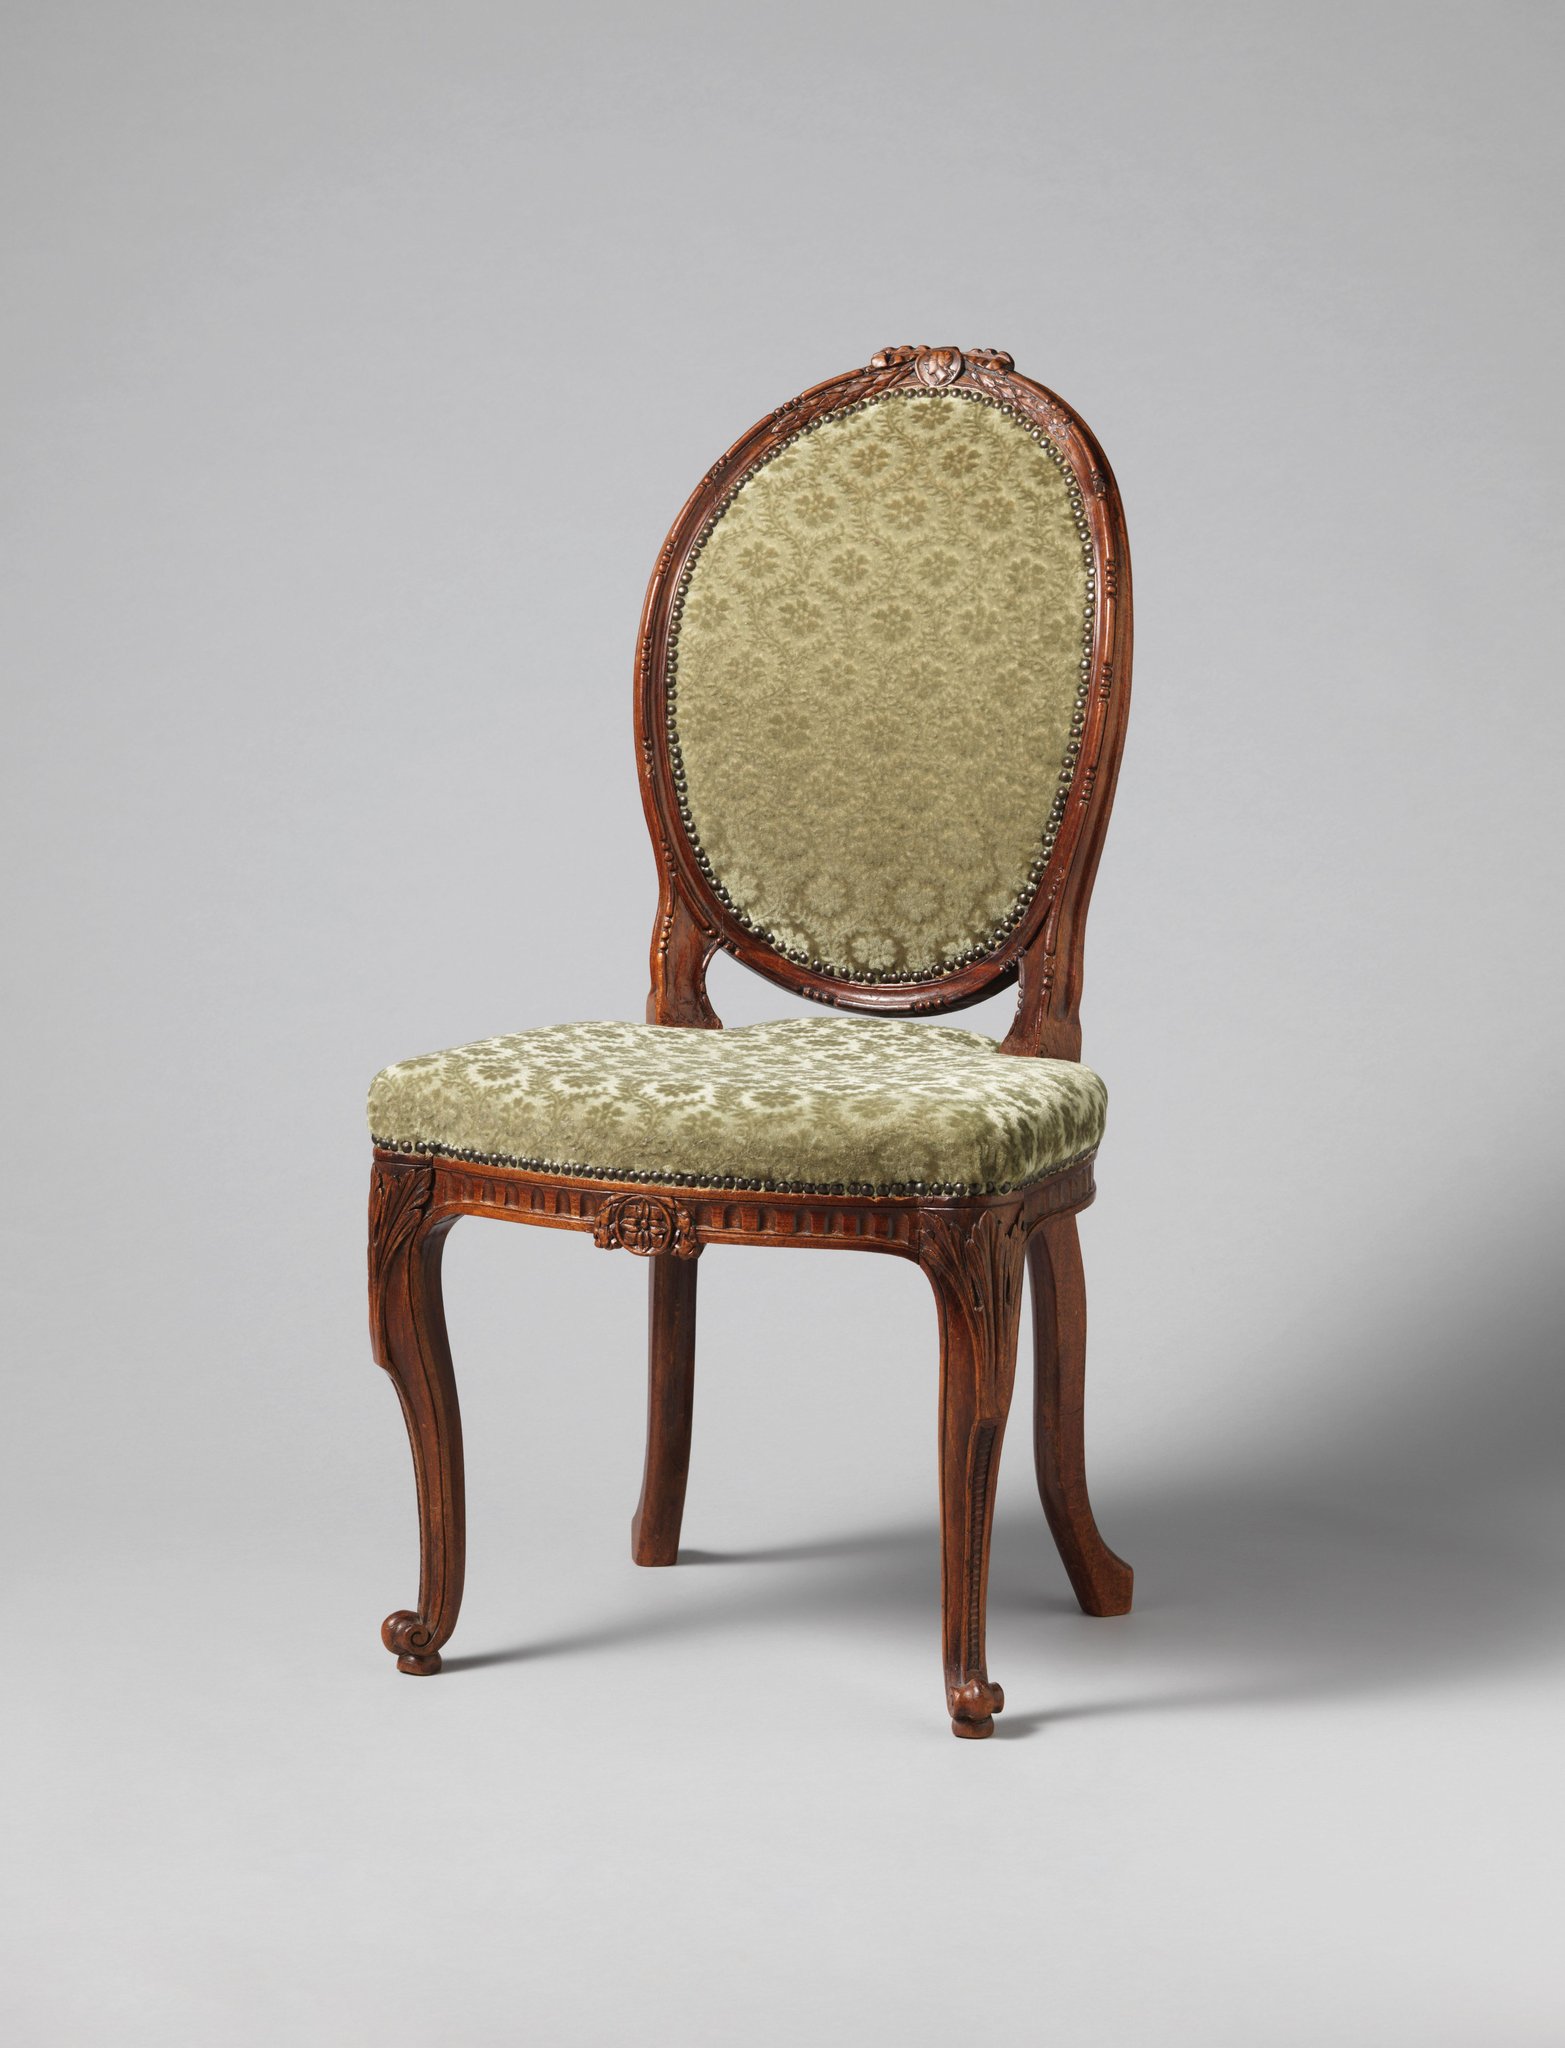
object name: furniture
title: Stoel met in de kap van de rug een in profiel gesneden vrouwenkop binnen een medaillon met ter weerszijden lauwerslingers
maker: Anonymous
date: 1775-1780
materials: wood, textile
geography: netherlands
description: Stoel van mahoniehout, bekleed met groene trijp (niet oorspronkelijk). De twee licht S-vormig gebogen poten zijn versierd met een geribde band die wordt bekroond door een groot motief an acanthusbladeren. De krachtig gebogen achterpoten zijn onversierd. De rechte zitregel vertoont aan voorzijde en zijkanten cannelures, in het midden van de voorzijde onderbroken door een rond medaillon met rozet waarvan ter weerszijden laurierslingers afhangen. Langs de ovale, licht holle rug en de hoge, C-vormig gebogen steunen daarvan lopt een lijst van afwisselend staven en drie parels. Deze wordt aan de bovenzijde onderbroken door een rond medaillon met een vrouwenkop in profiel, naar links gewend, hangend aan een strik en ter weerszijden geflankeerd door afhangende lauwerslingers. Genummerd aan de binnenzijde van de voorregel: VII met eronder twee strepen, er boven één; verder nog de letter C met dubbele punt.